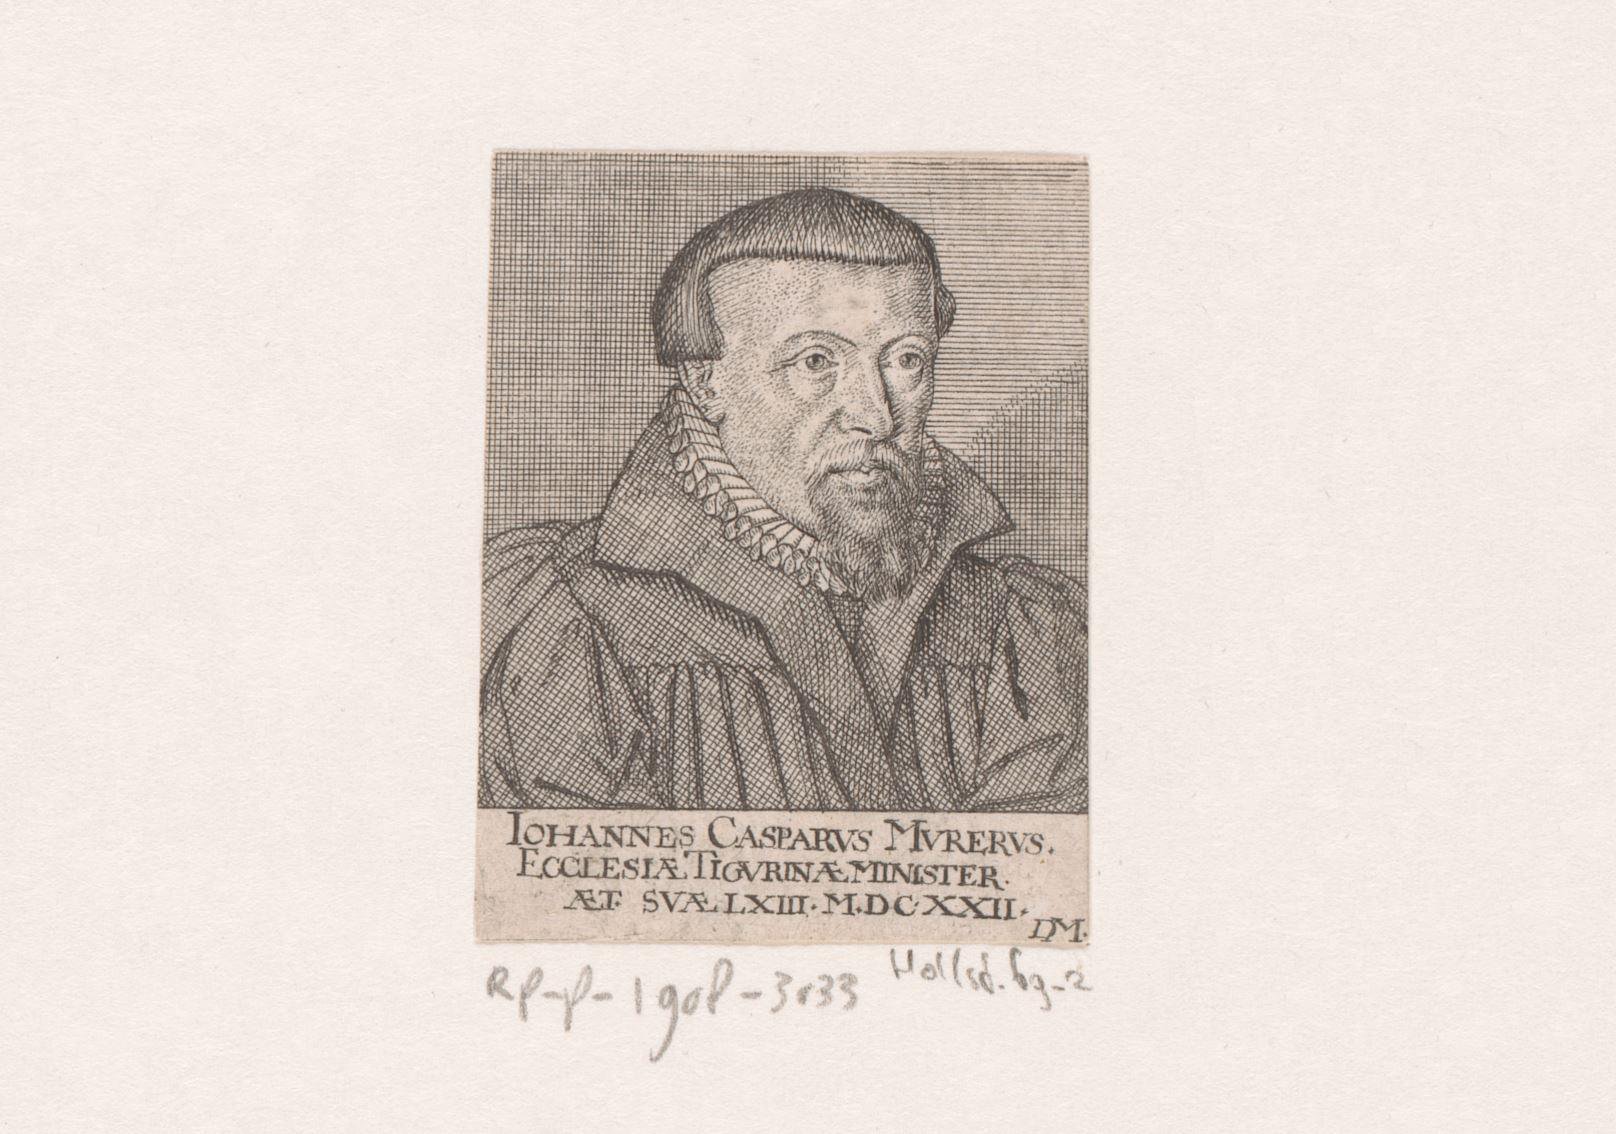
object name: print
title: Portretten van priesters en wetenschappers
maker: dietrich meyer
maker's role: painter, print maker, publisher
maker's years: 1572-1658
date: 1622-1658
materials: paper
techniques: engraving, etching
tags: theologian, historical persons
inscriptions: collector's mark: Lugt 2228